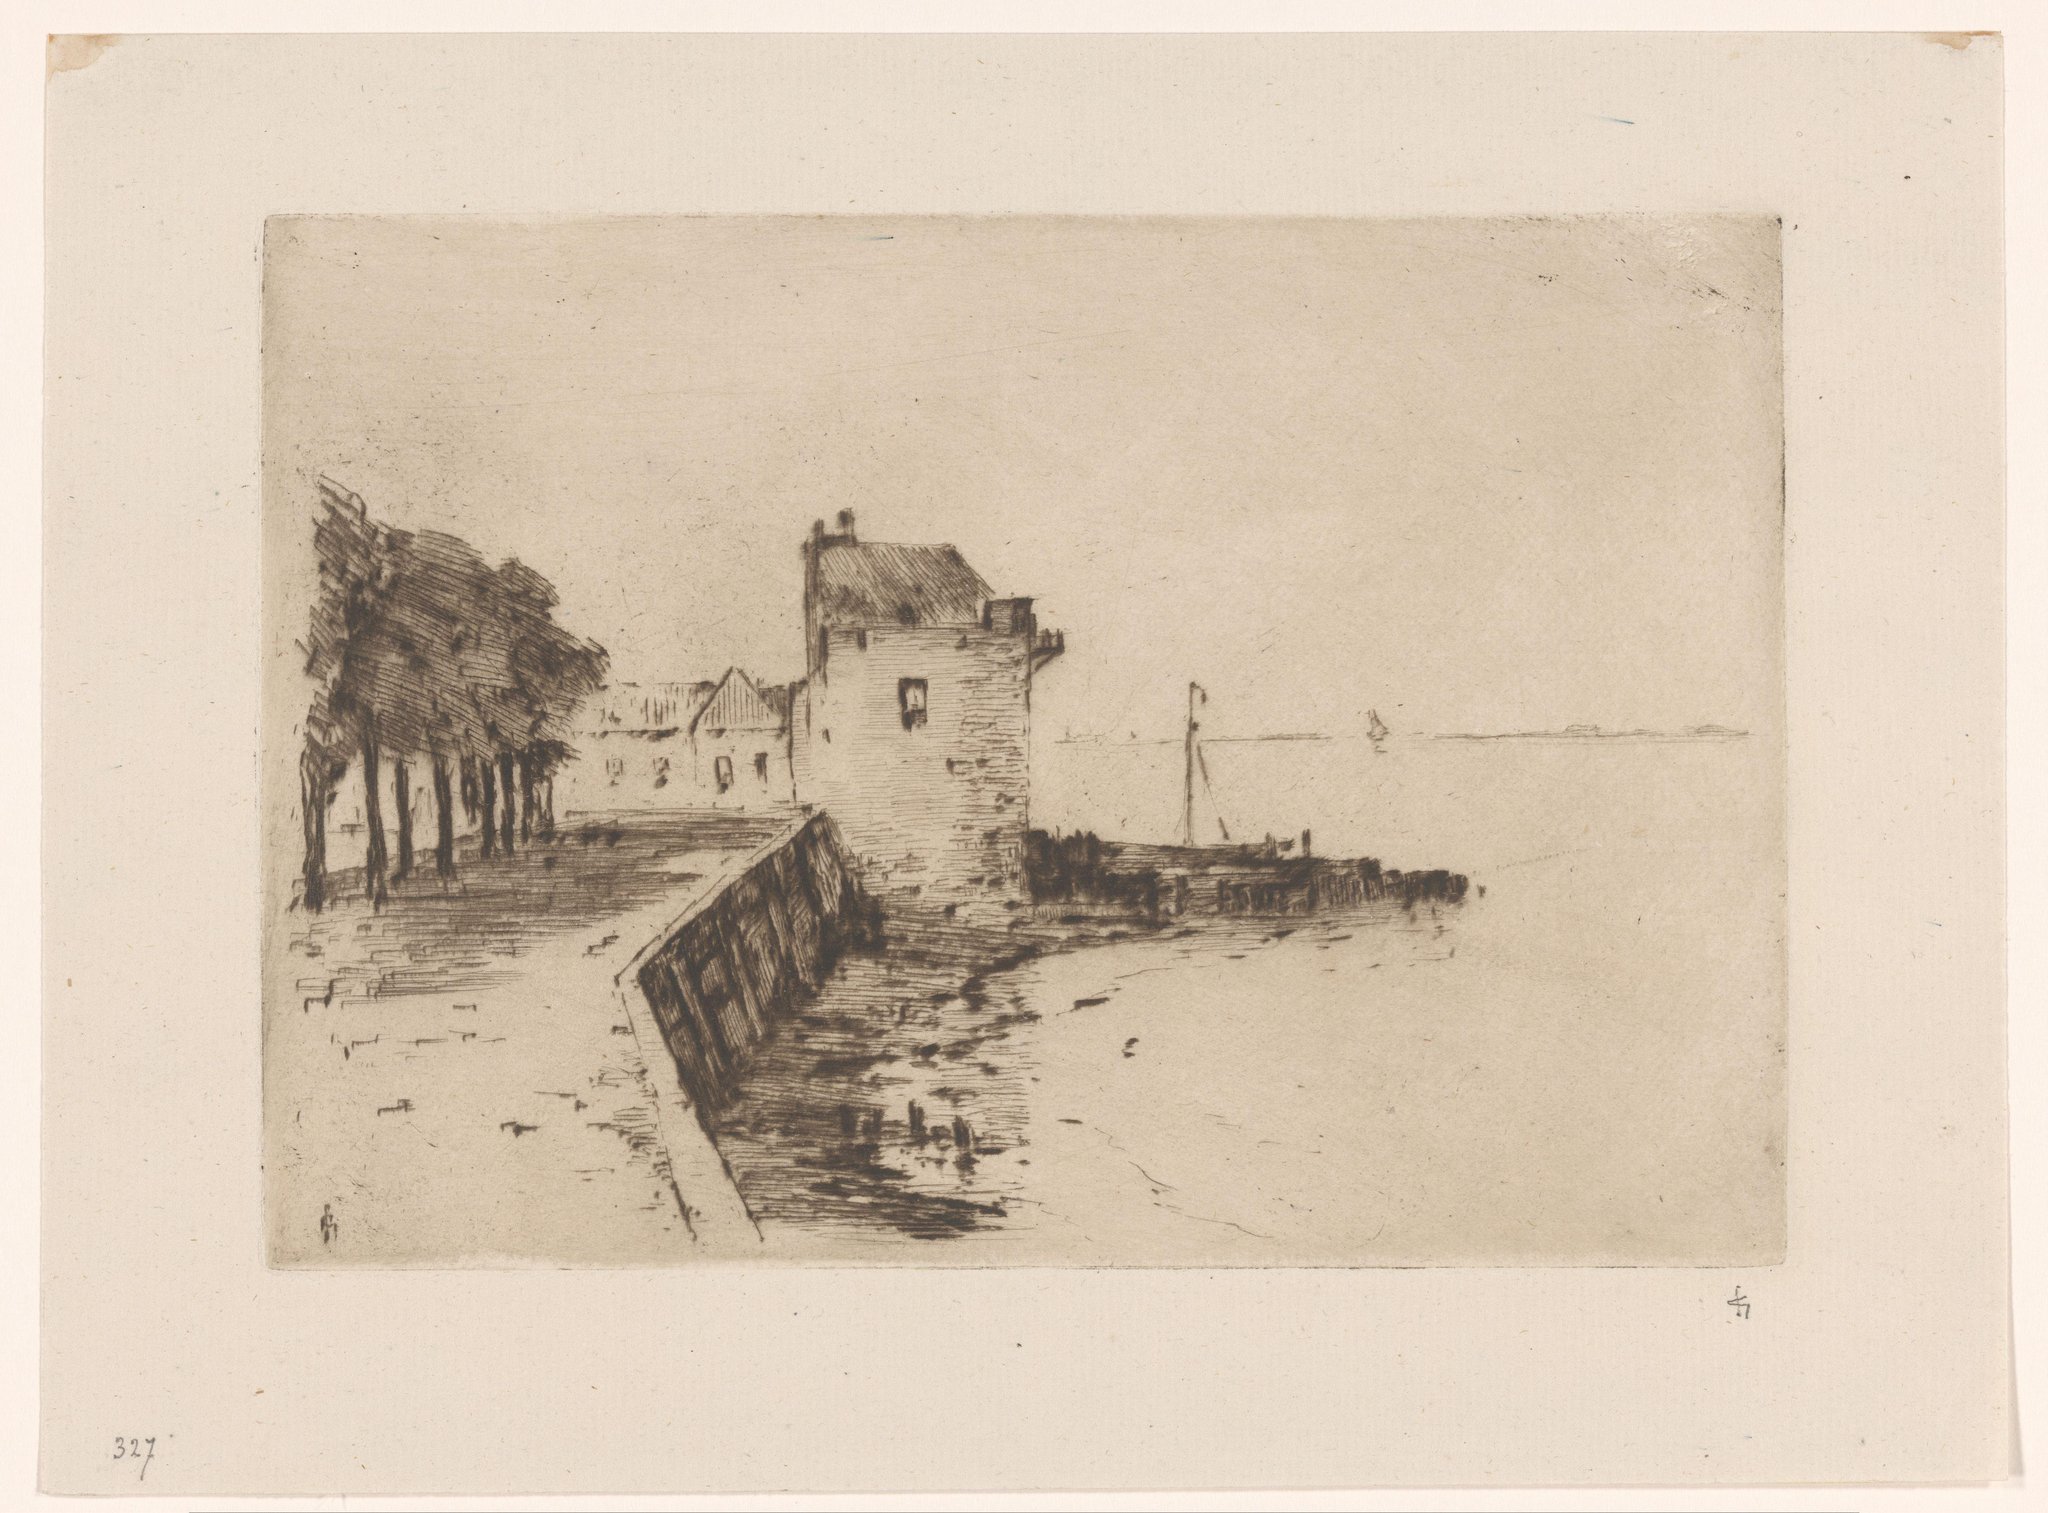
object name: print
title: Campveerse Toren in Veere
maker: carel nicolaas storm van s-gravesande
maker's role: draughtsman, print maker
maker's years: 1841-1924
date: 1889-1902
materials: paper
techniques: drypoint, intaglio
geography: netherlands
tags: towers ~ fortified city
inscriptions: collector's mark: Lugt 2228, number: ‘327’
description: Mogelijk vermeld in: Storm van 's-Gravesande, Charles. Catalogue des eaux-fortes et lithographies. New York: s.n., 1903, of in een onbekende latere uitgave van het manuscript. Vermoedelijk vermeld als catalogusnummer 327.